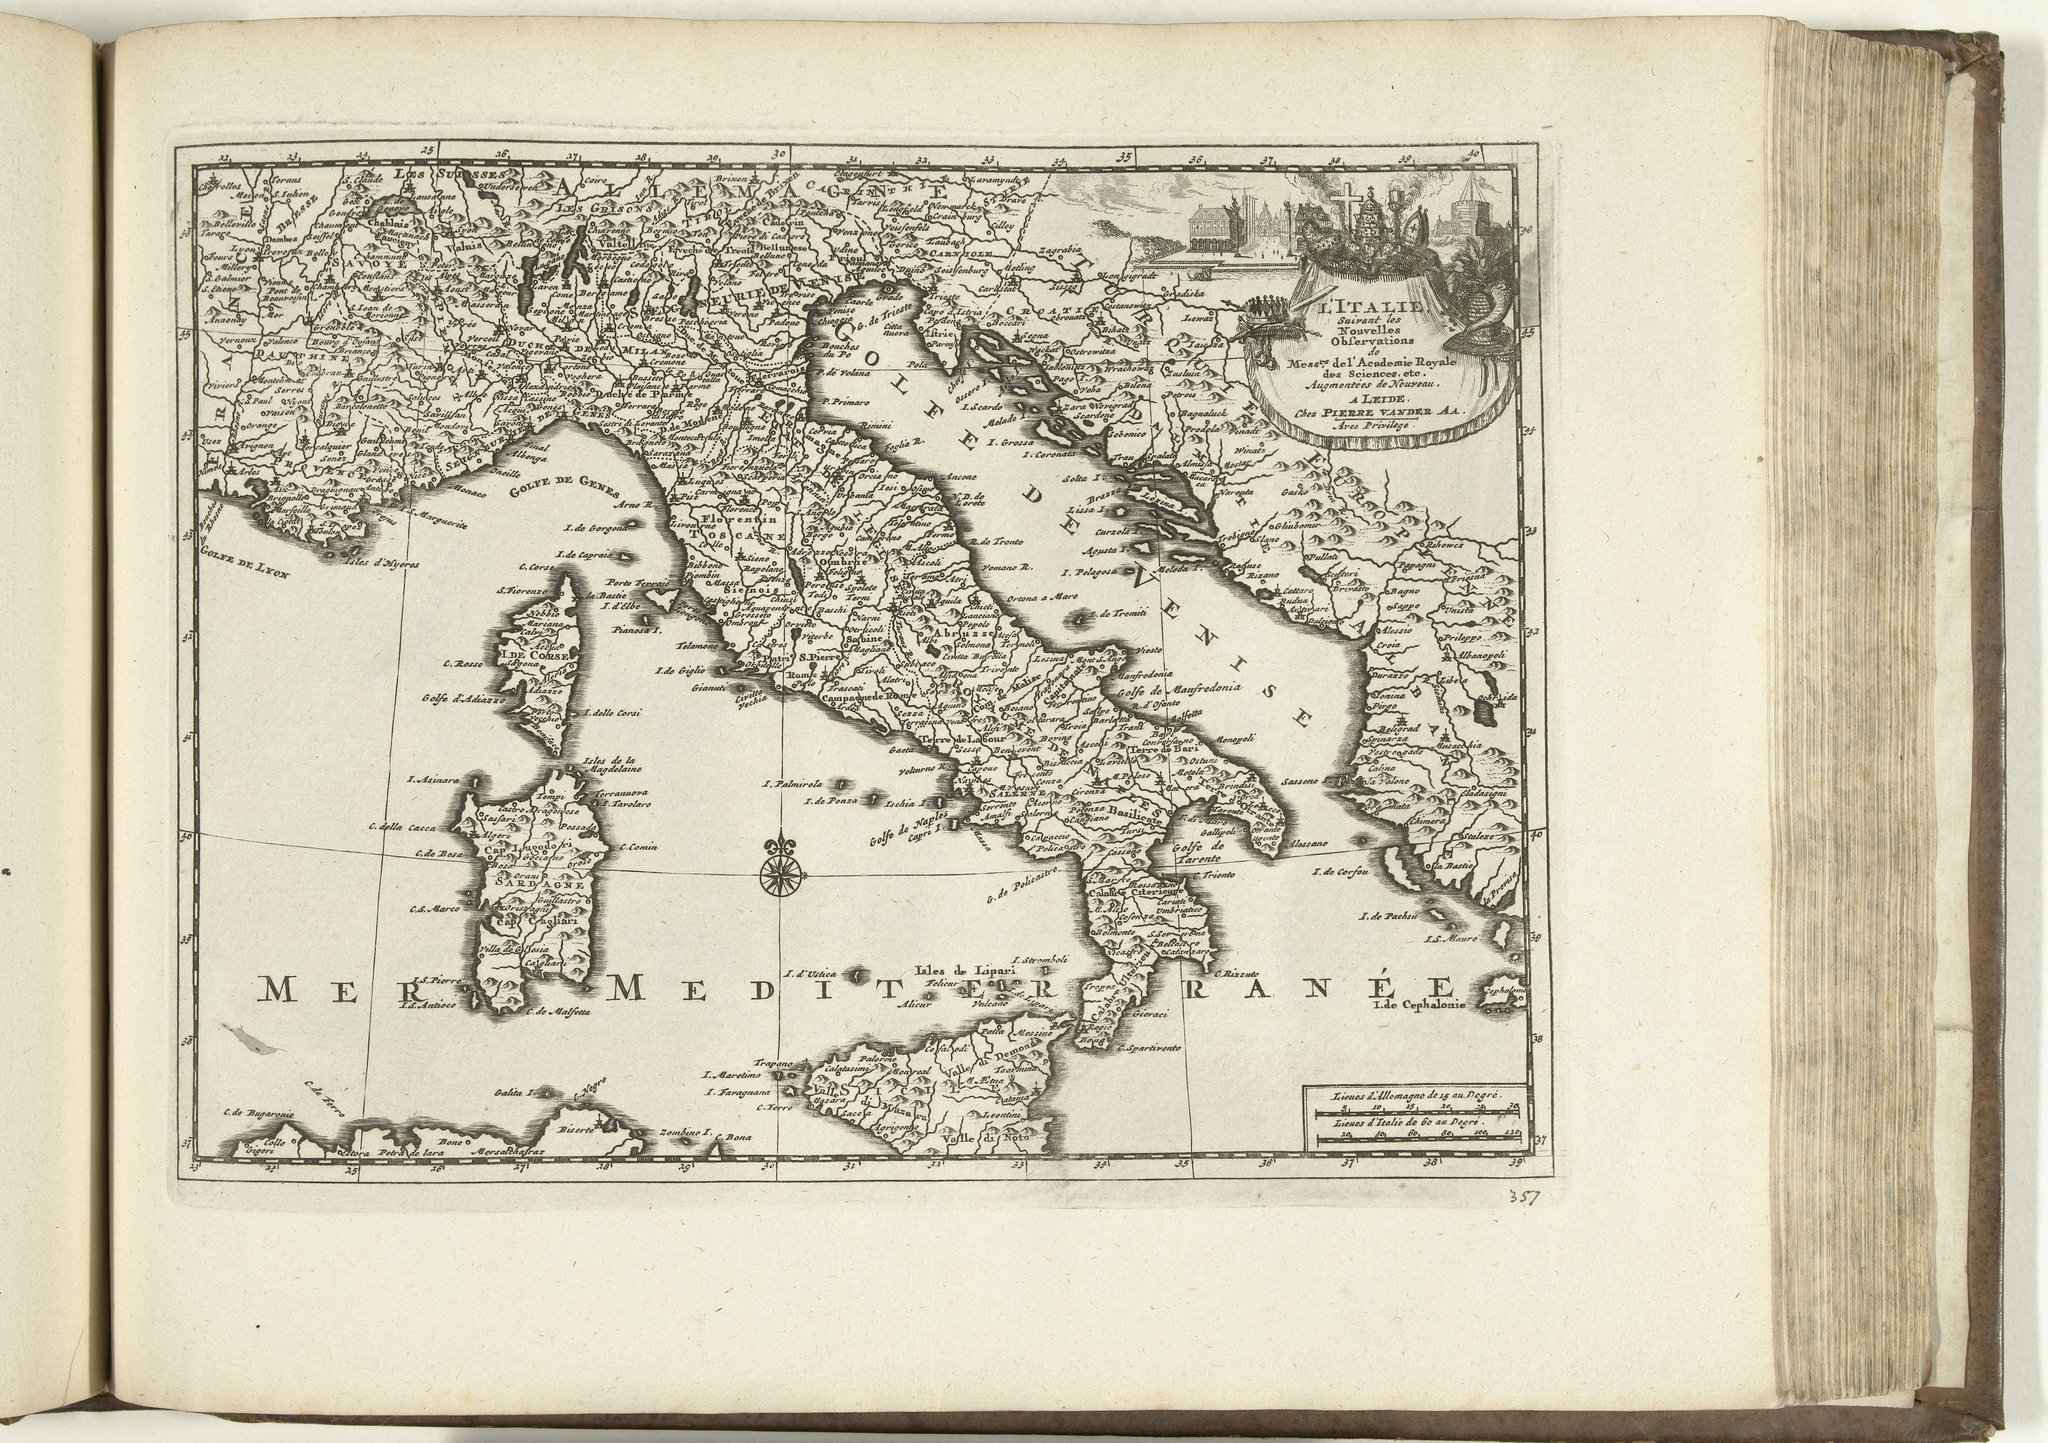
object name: map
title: Kaart van Italië, 1726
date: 1726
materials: paper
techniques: engraving, etching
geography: northern netherlands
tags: maps of separate countries or regions, italy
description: Kaart van Italië. Plaat nr. 357 in deel XV van het prentwerk: Les Forces de l'Europe, Asie, Afrique et Amerique ... Comme aussi les Cartes des Côtes de France et d'Espagne uit 1726, dit tweede deel met 271 met de hand genummerde platen van vermaarde sterke steden en vestingen in het kader van de Spaanse Successieoorlog 1701-1713. Voor het merendeel zijn deze platen gekopieerd naar de anonieme Franse platen van vermaarde sterke steden en vestingen: in Les forces de l'Europe en in: Le theatre de la guerre, dans les Pays-Bas, beide oorspronkelijk uitgegeven door Nicolas de Fer te Parijs (1693-1697) in het kader van de Negenjarige Oorlog. Titel en opschriften in het Frans.